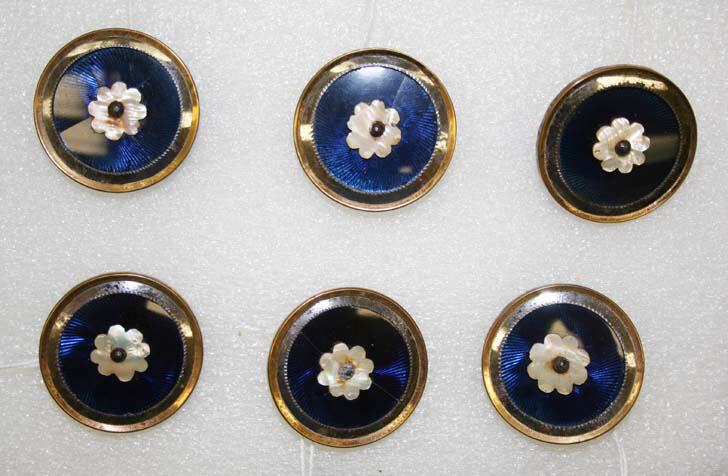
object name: button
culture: french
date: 1775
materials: glass, metal, pearl